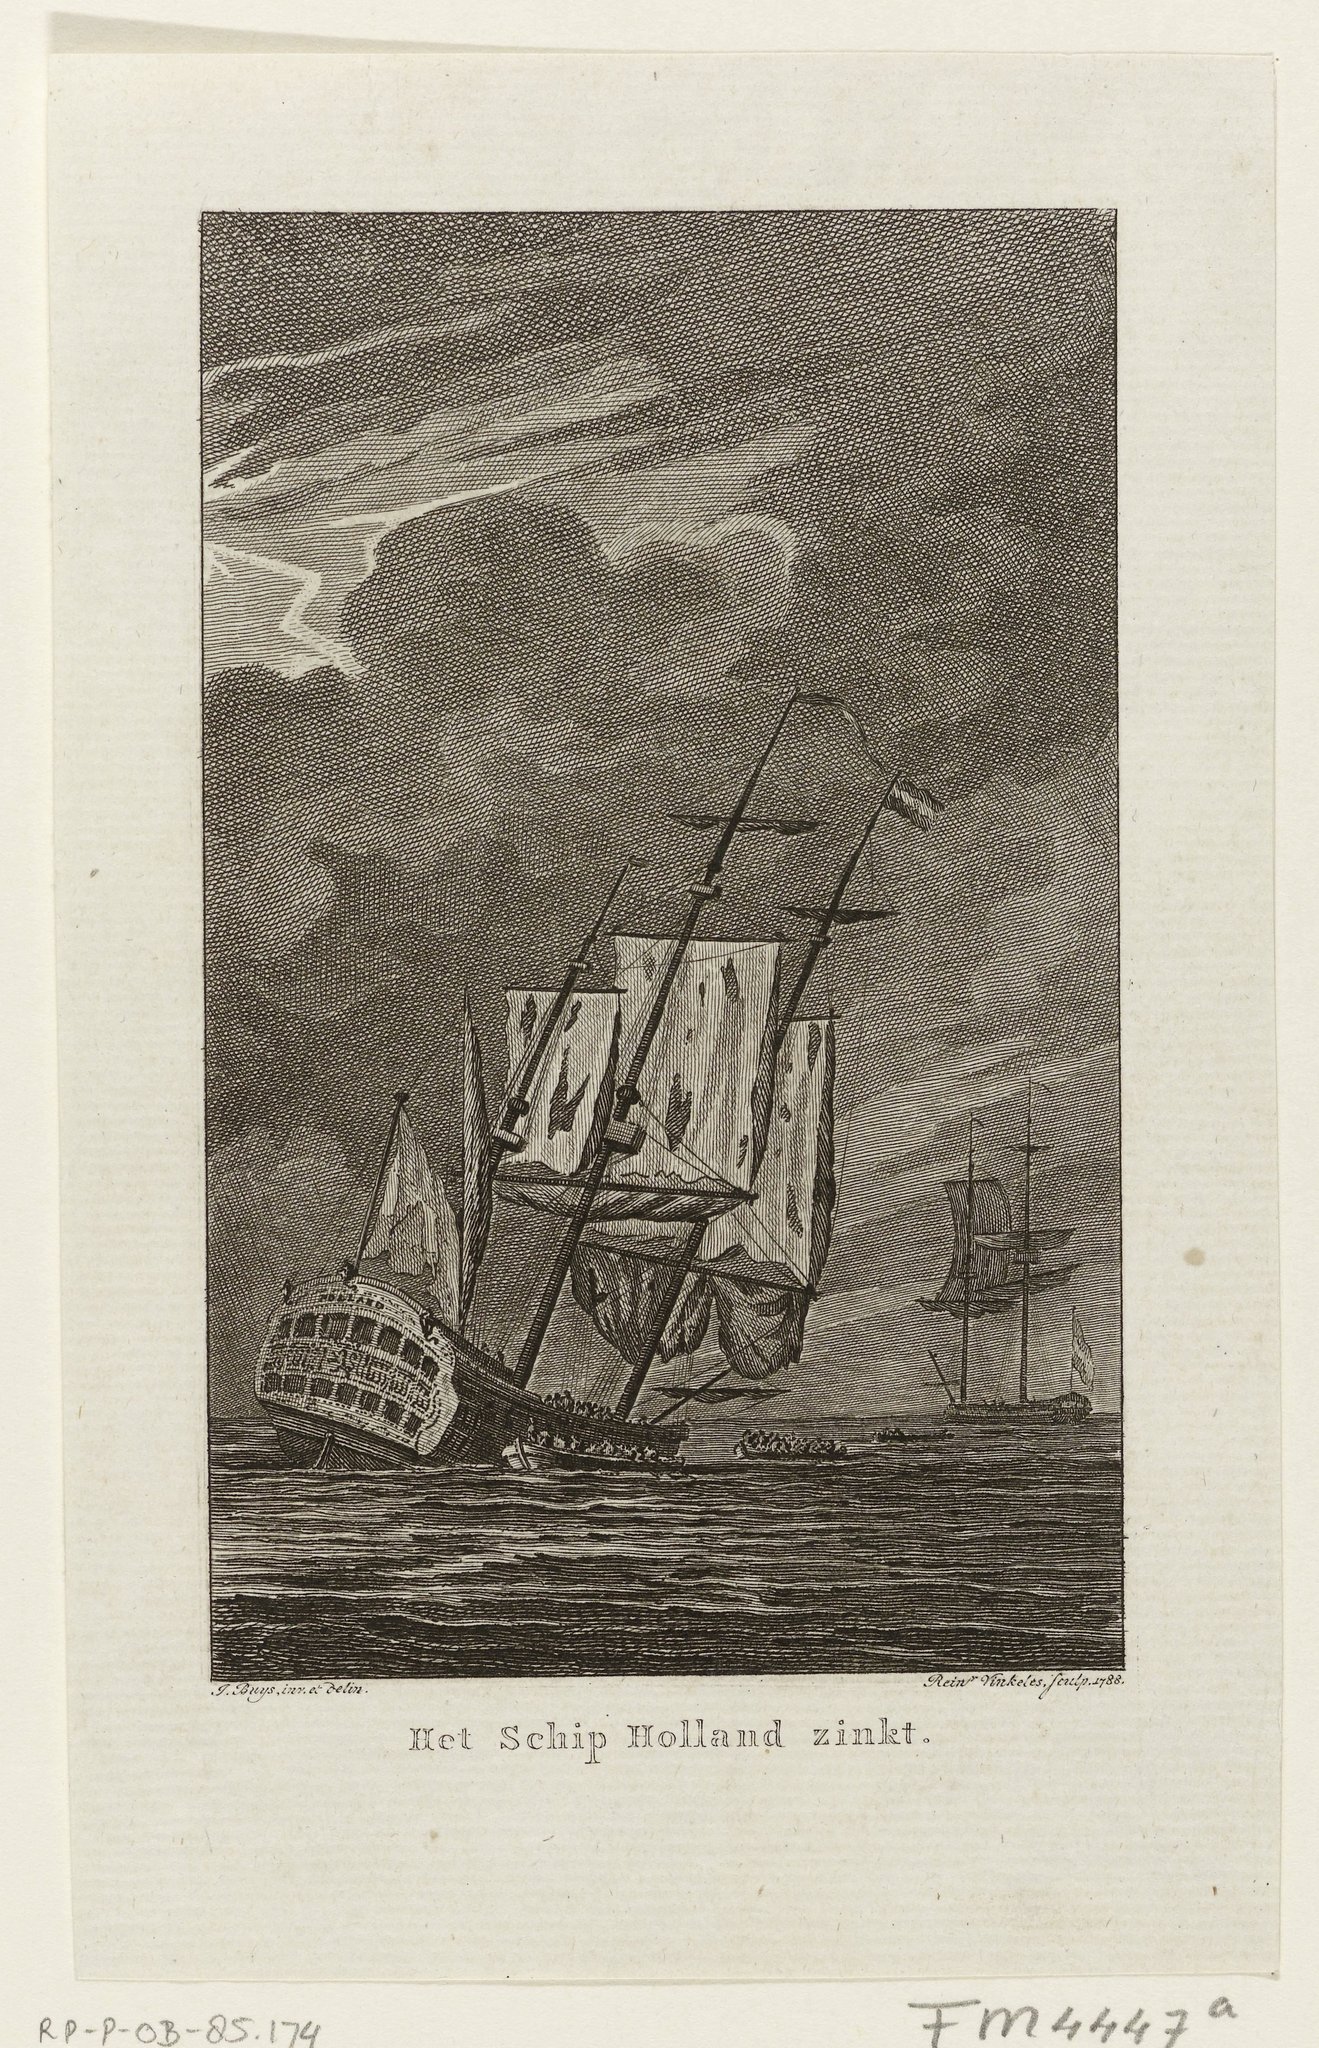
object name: history print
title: Het zinkende schip Holland, 1781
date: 1788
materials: paper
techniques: engraving, etching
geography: northern netherlands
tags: shipwreck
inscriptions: collector's mark: Lugt 2228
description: Gebruikt als illustratie in: P.A. Loosjes. Vaderlandsche historie, vervattende de geschiedenissen, der Vereenigde Nederlanden (...). Ten onmiddelyken vervolge van Wagenaar's Vaderlandsche historie. Dl. 3. Amsterdam: J. Allart, 1788.